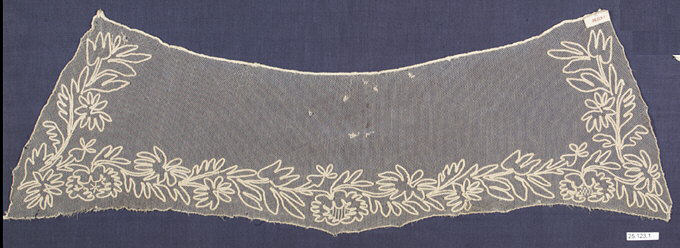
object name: collar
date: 1801-1900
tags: flowers